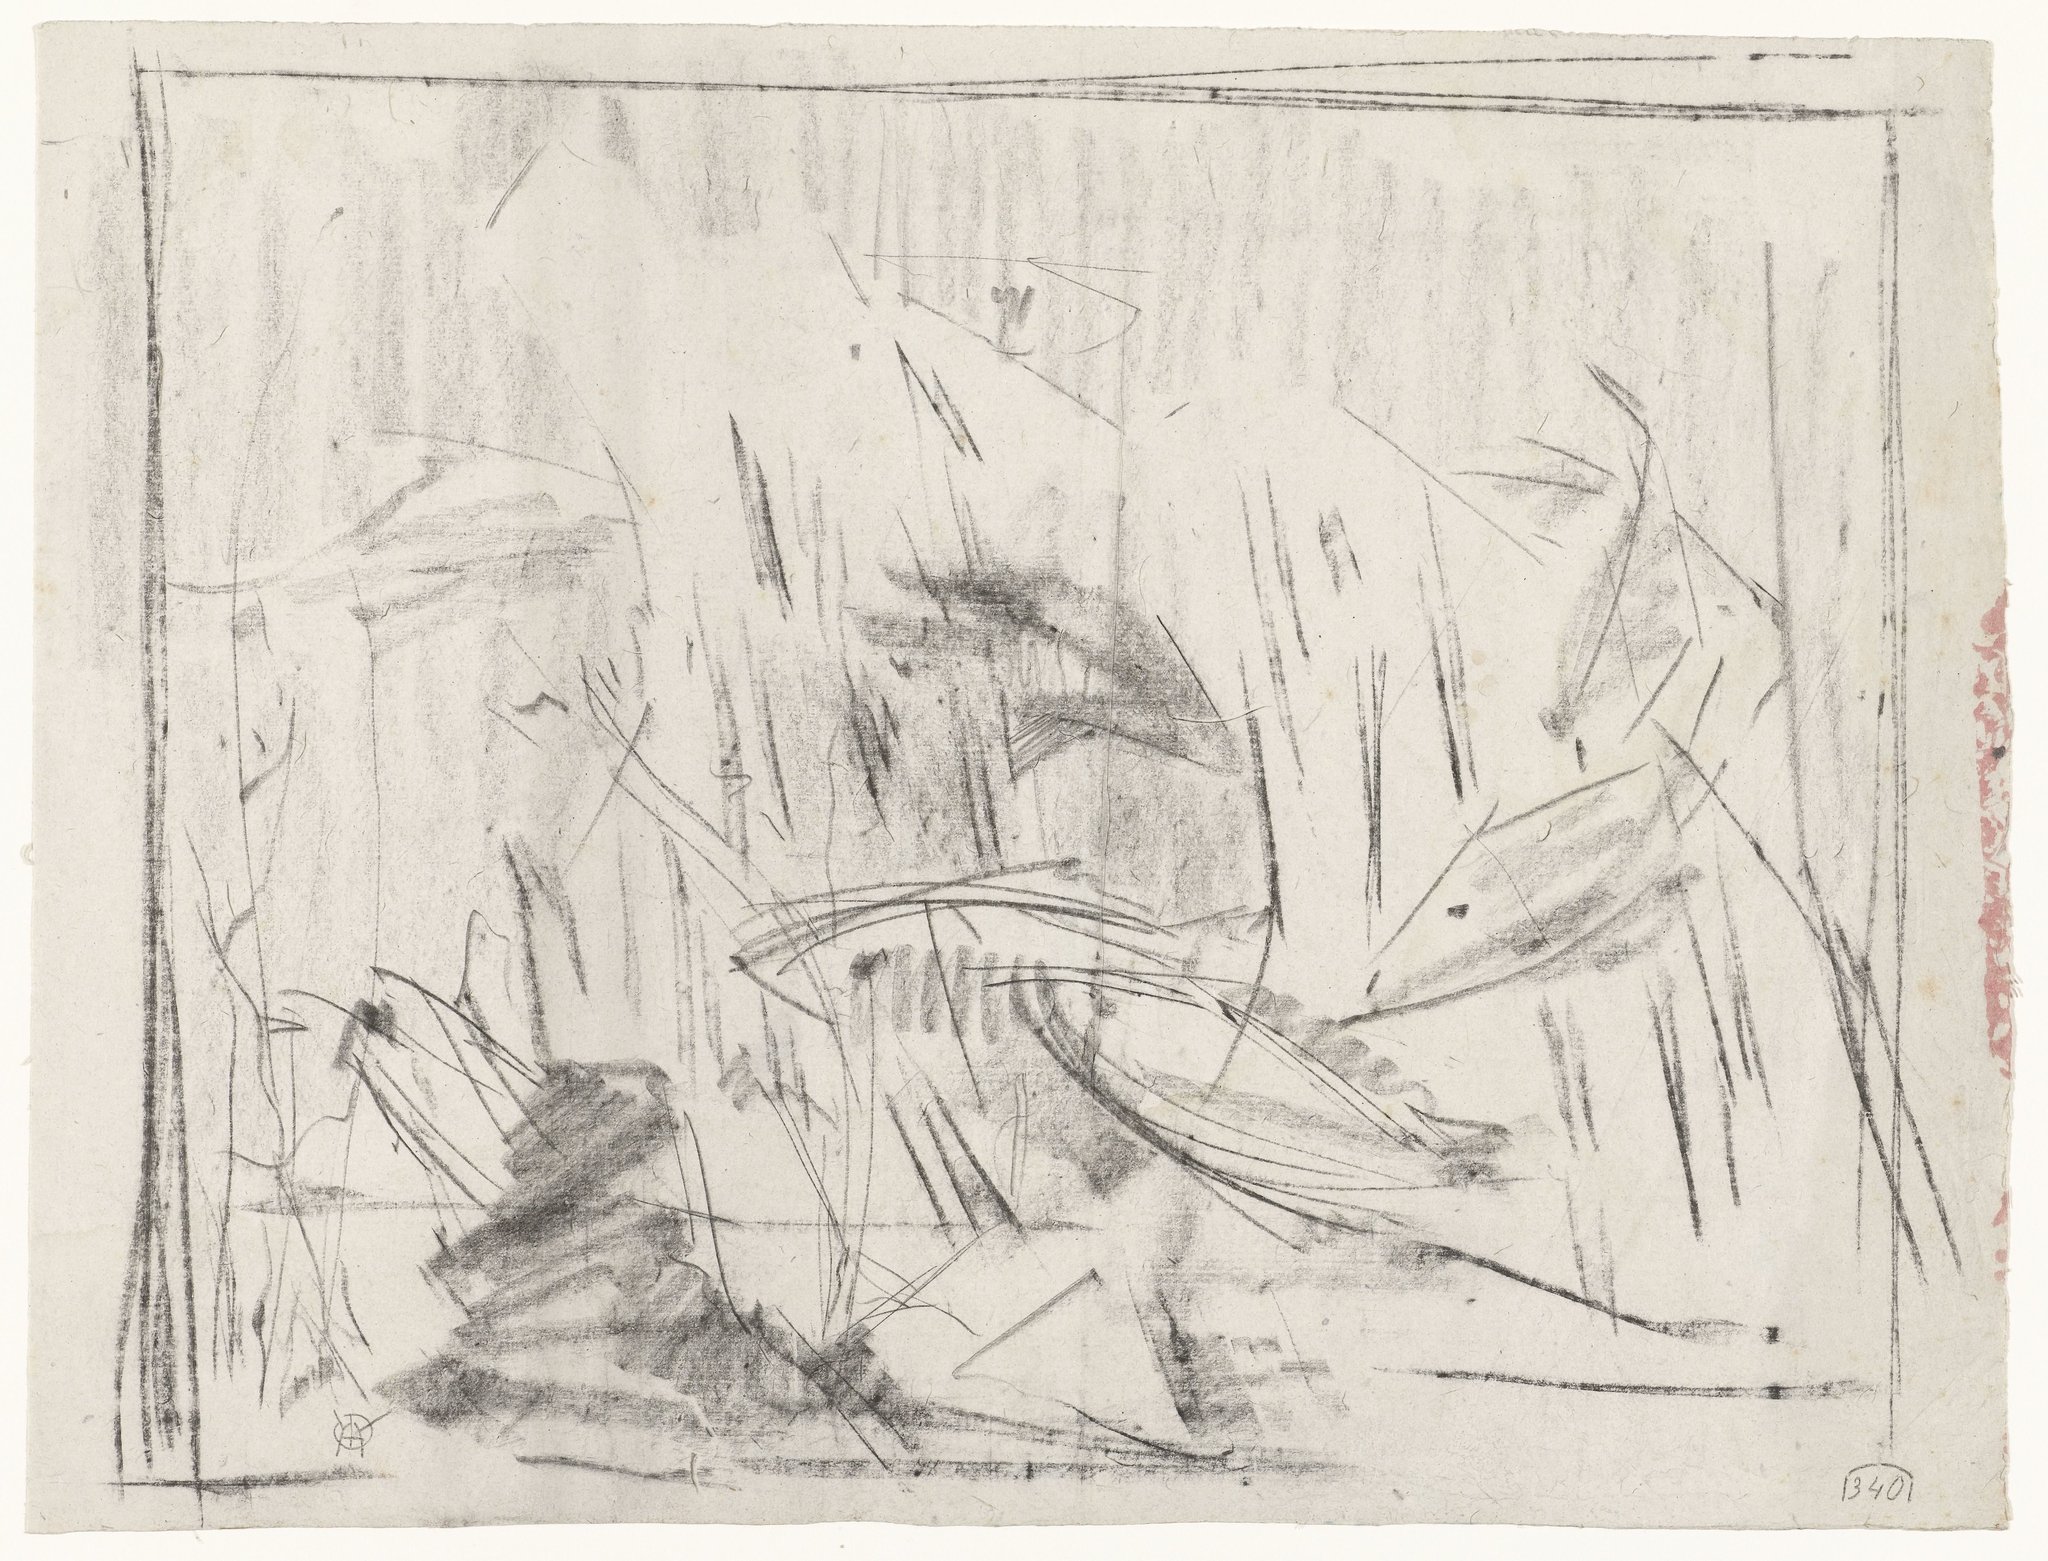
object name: drawing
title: Schets van vissen in een aquarium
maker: gerrit willem dijsselhof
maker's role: designer, draughtsman, print maker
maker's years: 1866-1924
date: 1876-1924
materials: chalk, paper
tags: aquarium, fishes